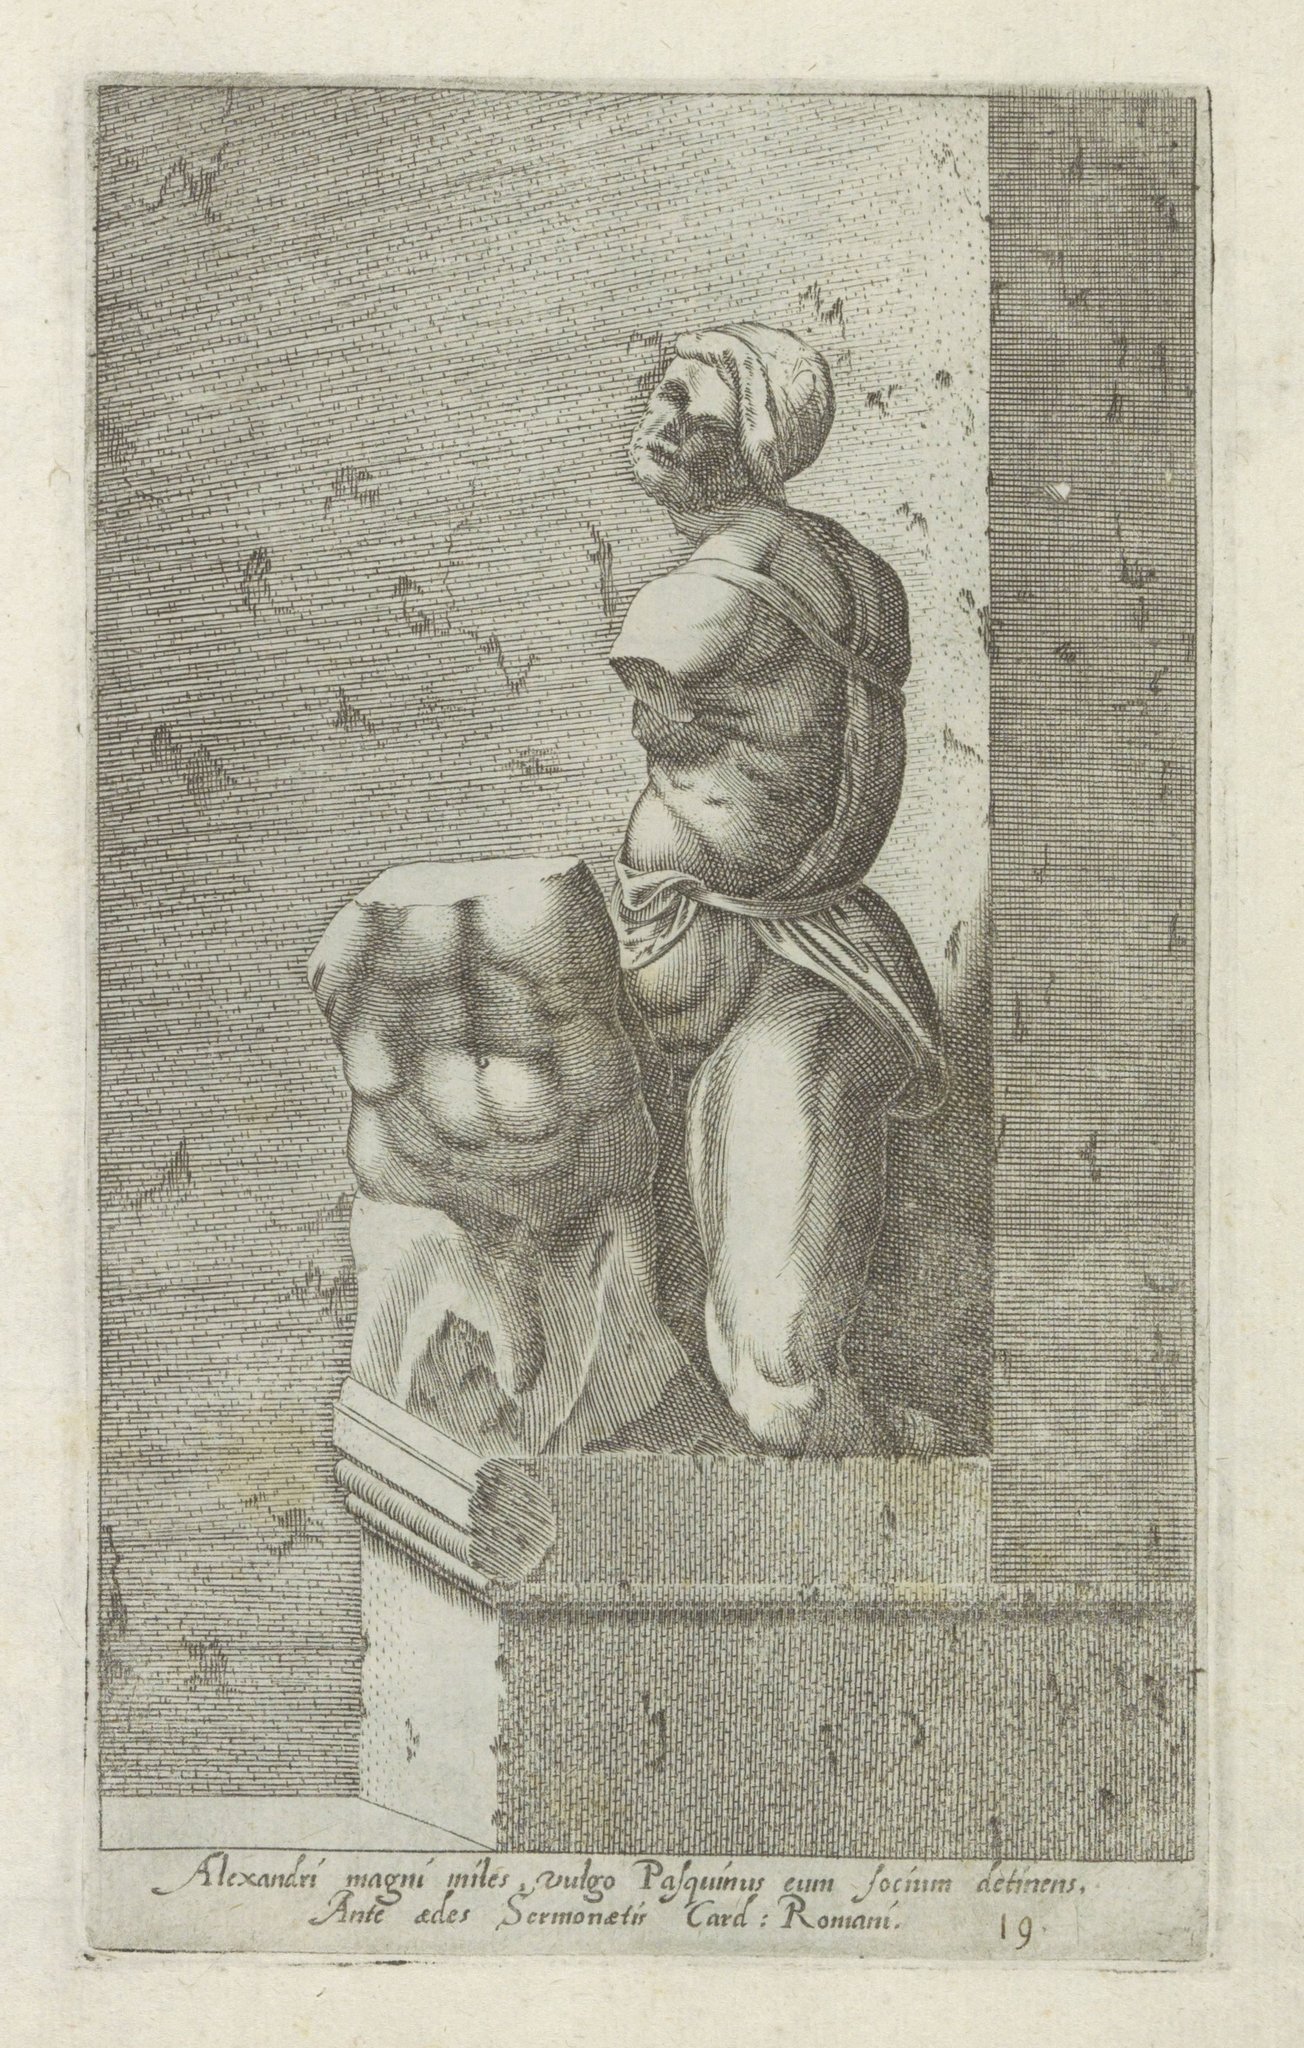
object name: album leaf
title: Sculptuur van Pasquino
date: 1584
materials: paper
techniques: engraving, intaglio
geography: rome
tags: communication by means of 'statue parlanti', such as marforio and pasquino in rome, piece of sculpture, reproduction of a piece of sculpture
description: Sculptuur van Pasquino, naast het Palazzo Braschi, een van de pratende beelden in Rome. Onderschrift in het Latijn. Prent maakt deel uit van een album.